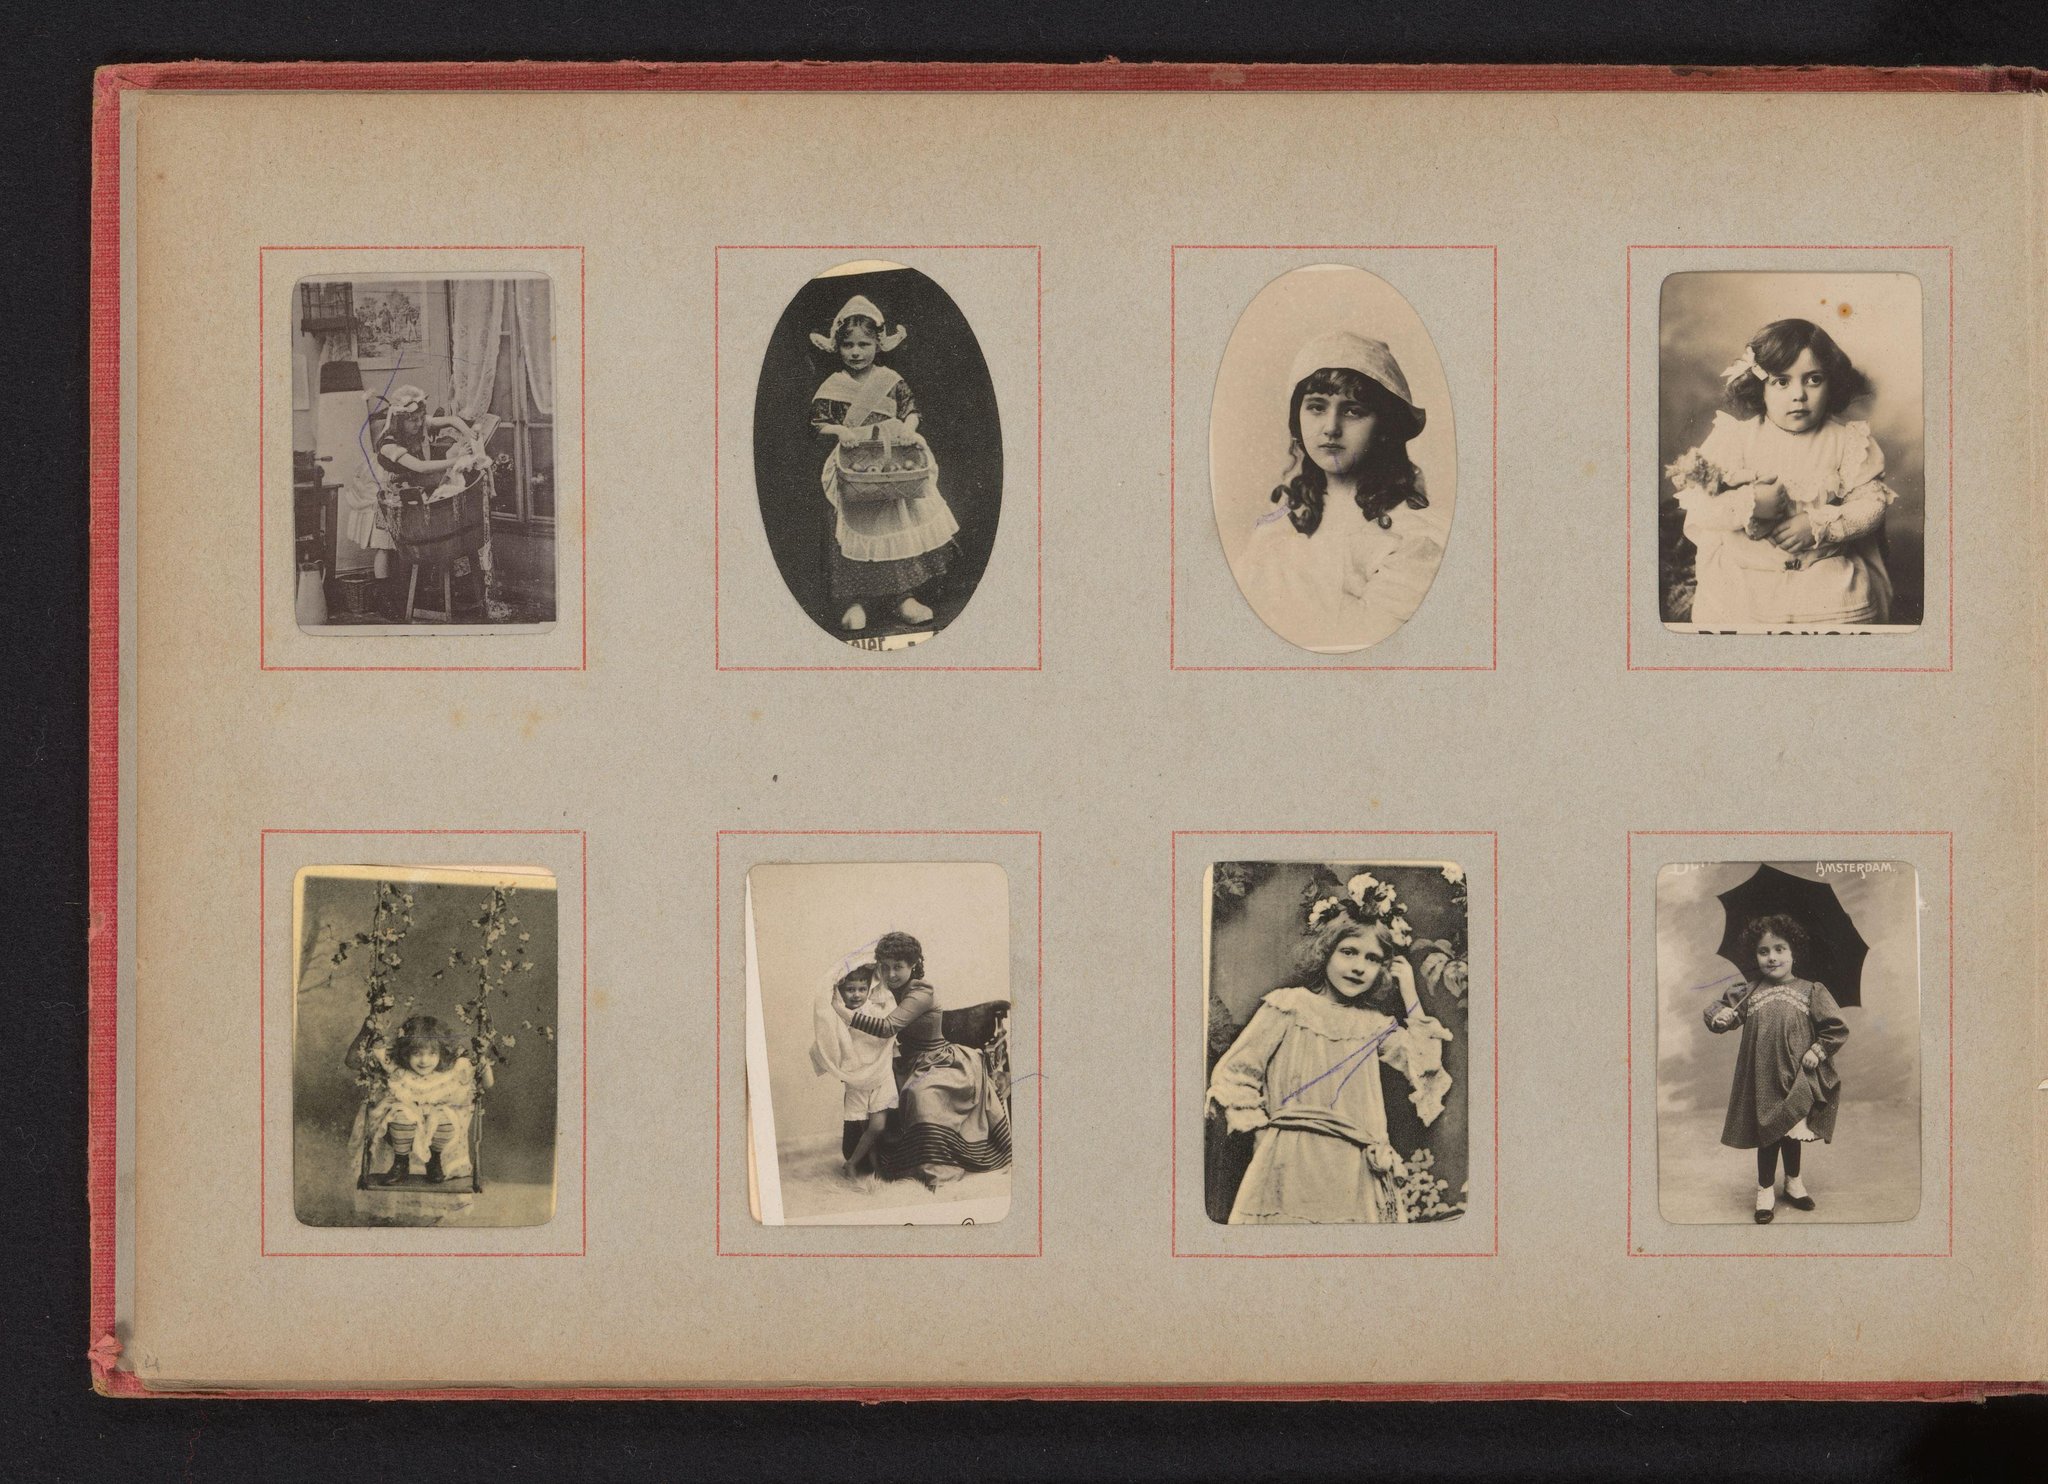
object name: album leaf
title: Kinderportretten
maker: Anonymous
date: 1890-1900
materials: cardboard, paper, photographic support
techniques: photograph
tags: girl (child between toddler and youth), umbrella, folk costume, regional costume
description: Acht portretten van kinderen, waaronder een meisje in klederdracht en een meisje met een paraplu. Deze pagina maakt deel uit van een album.